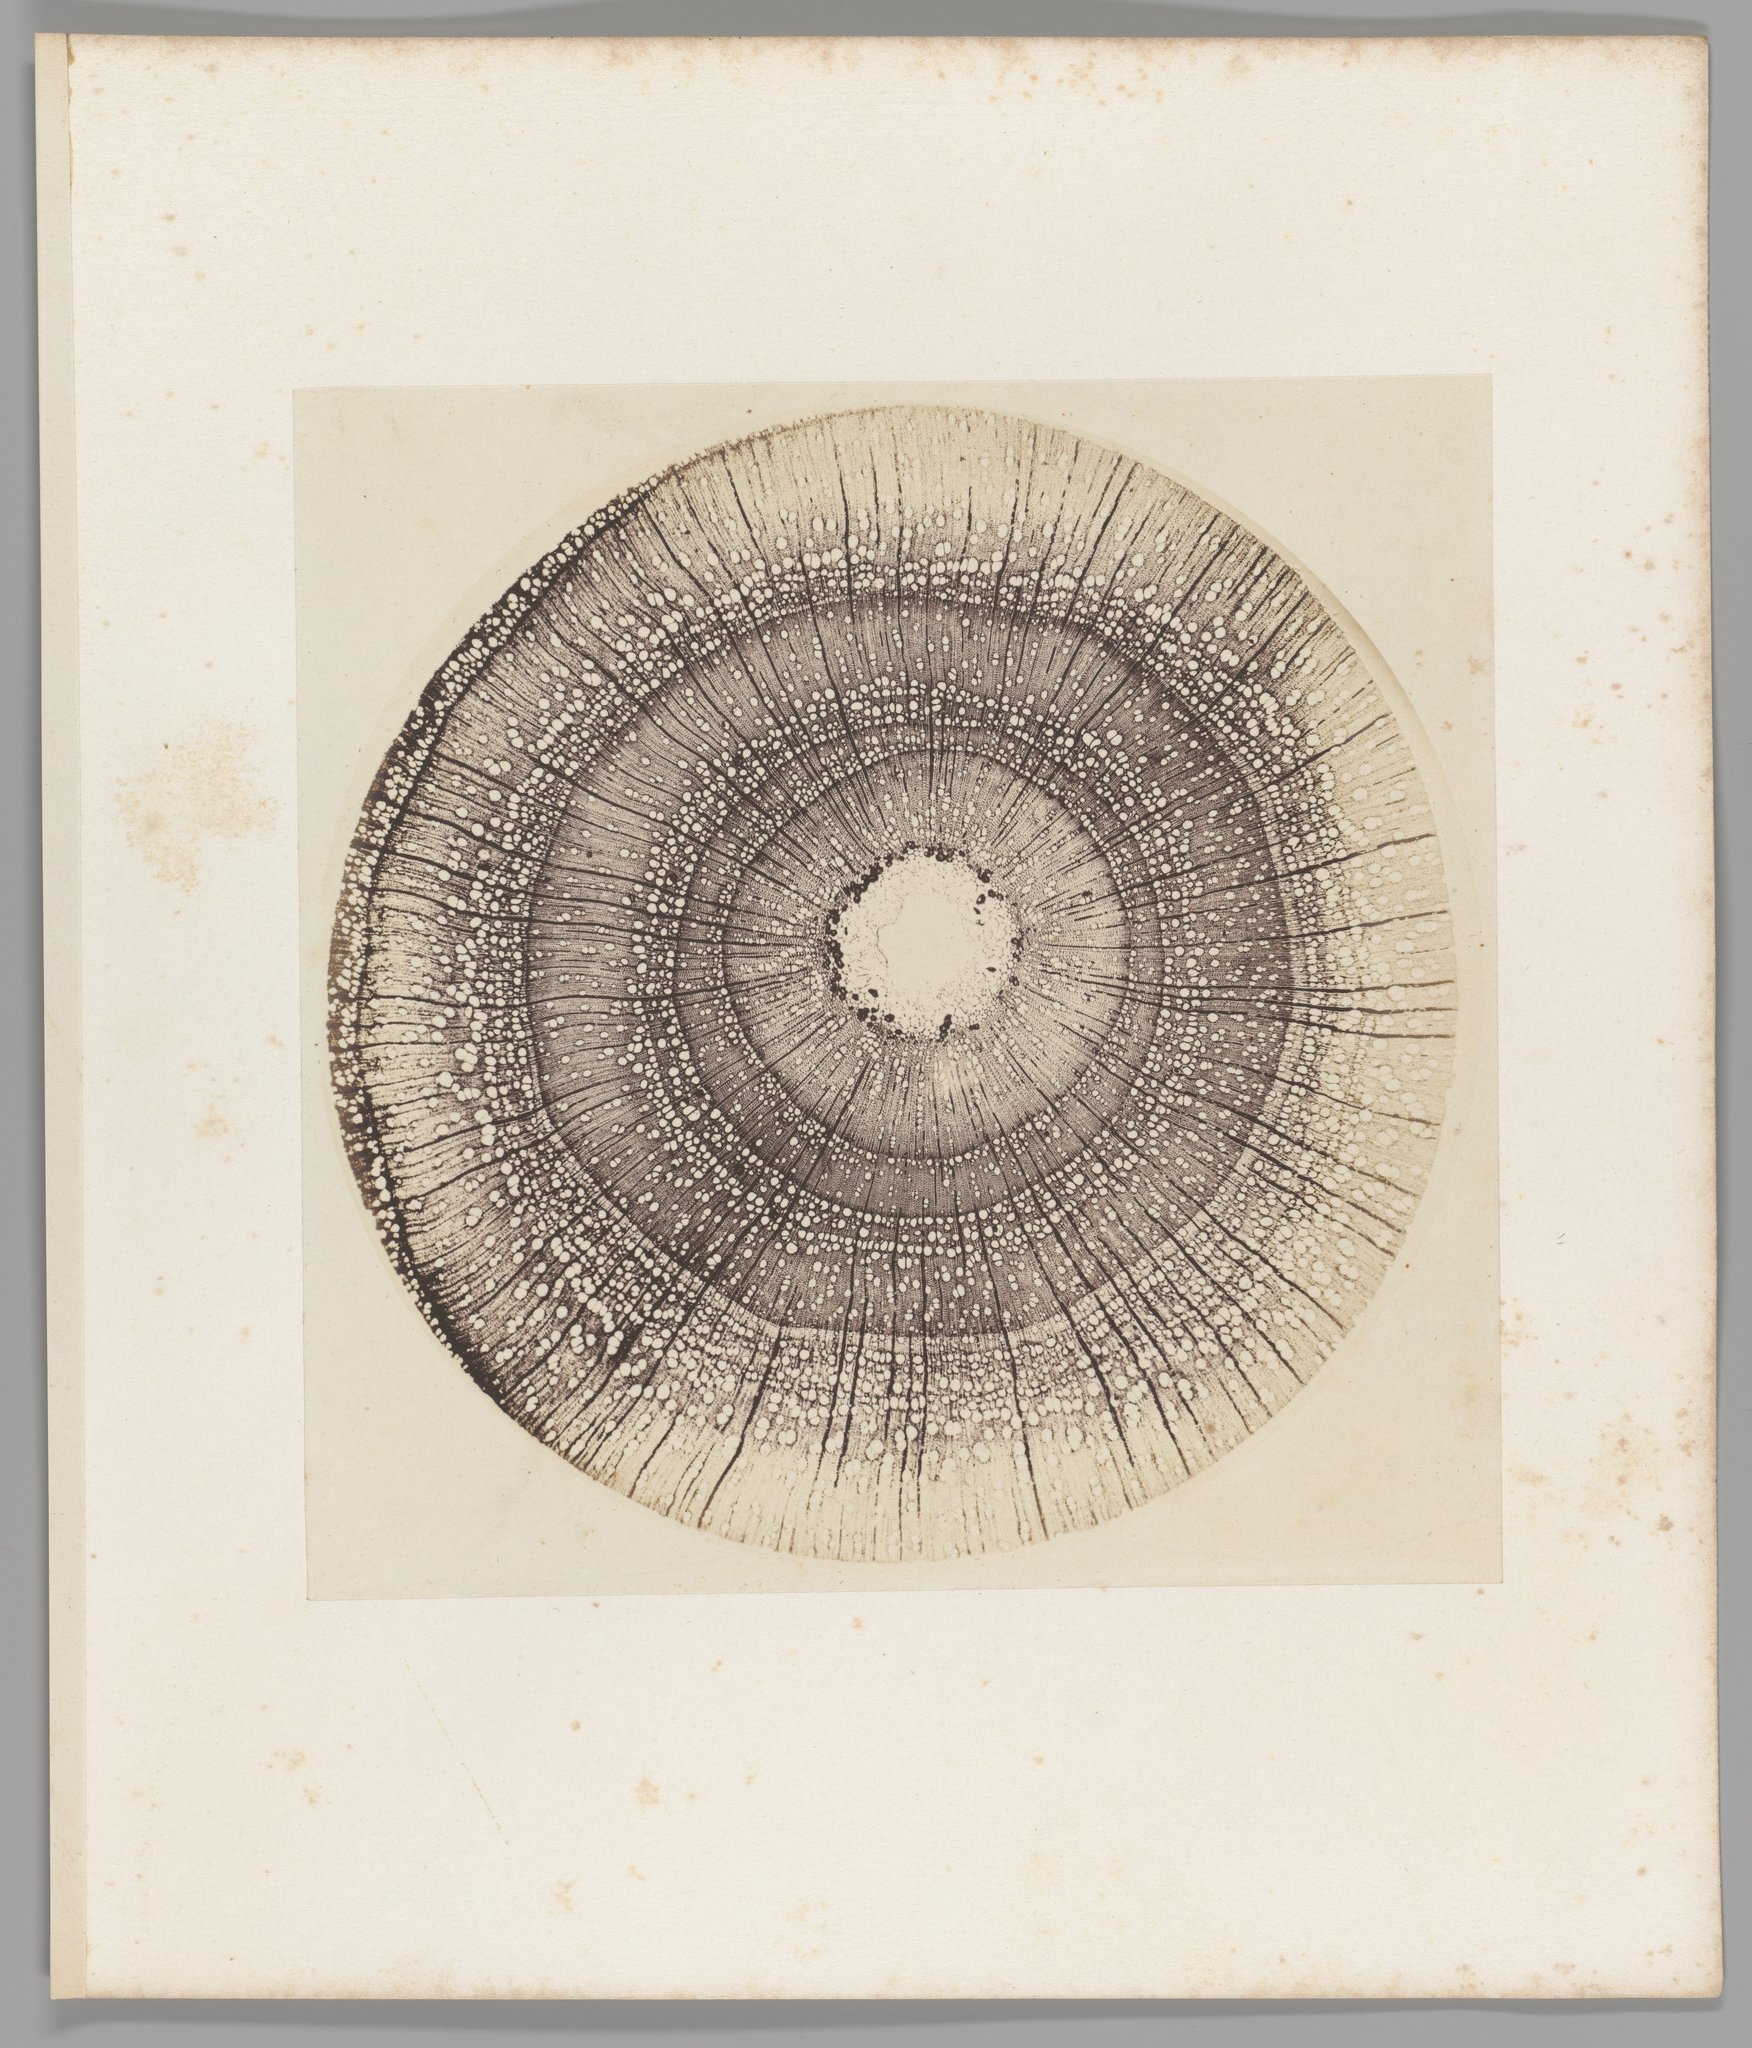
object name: photograph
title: [Untitled]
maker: auguste-adolphe bertsch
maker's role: artist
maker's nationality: french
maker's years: 1813-1871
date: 1853-1857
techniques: salted paper print